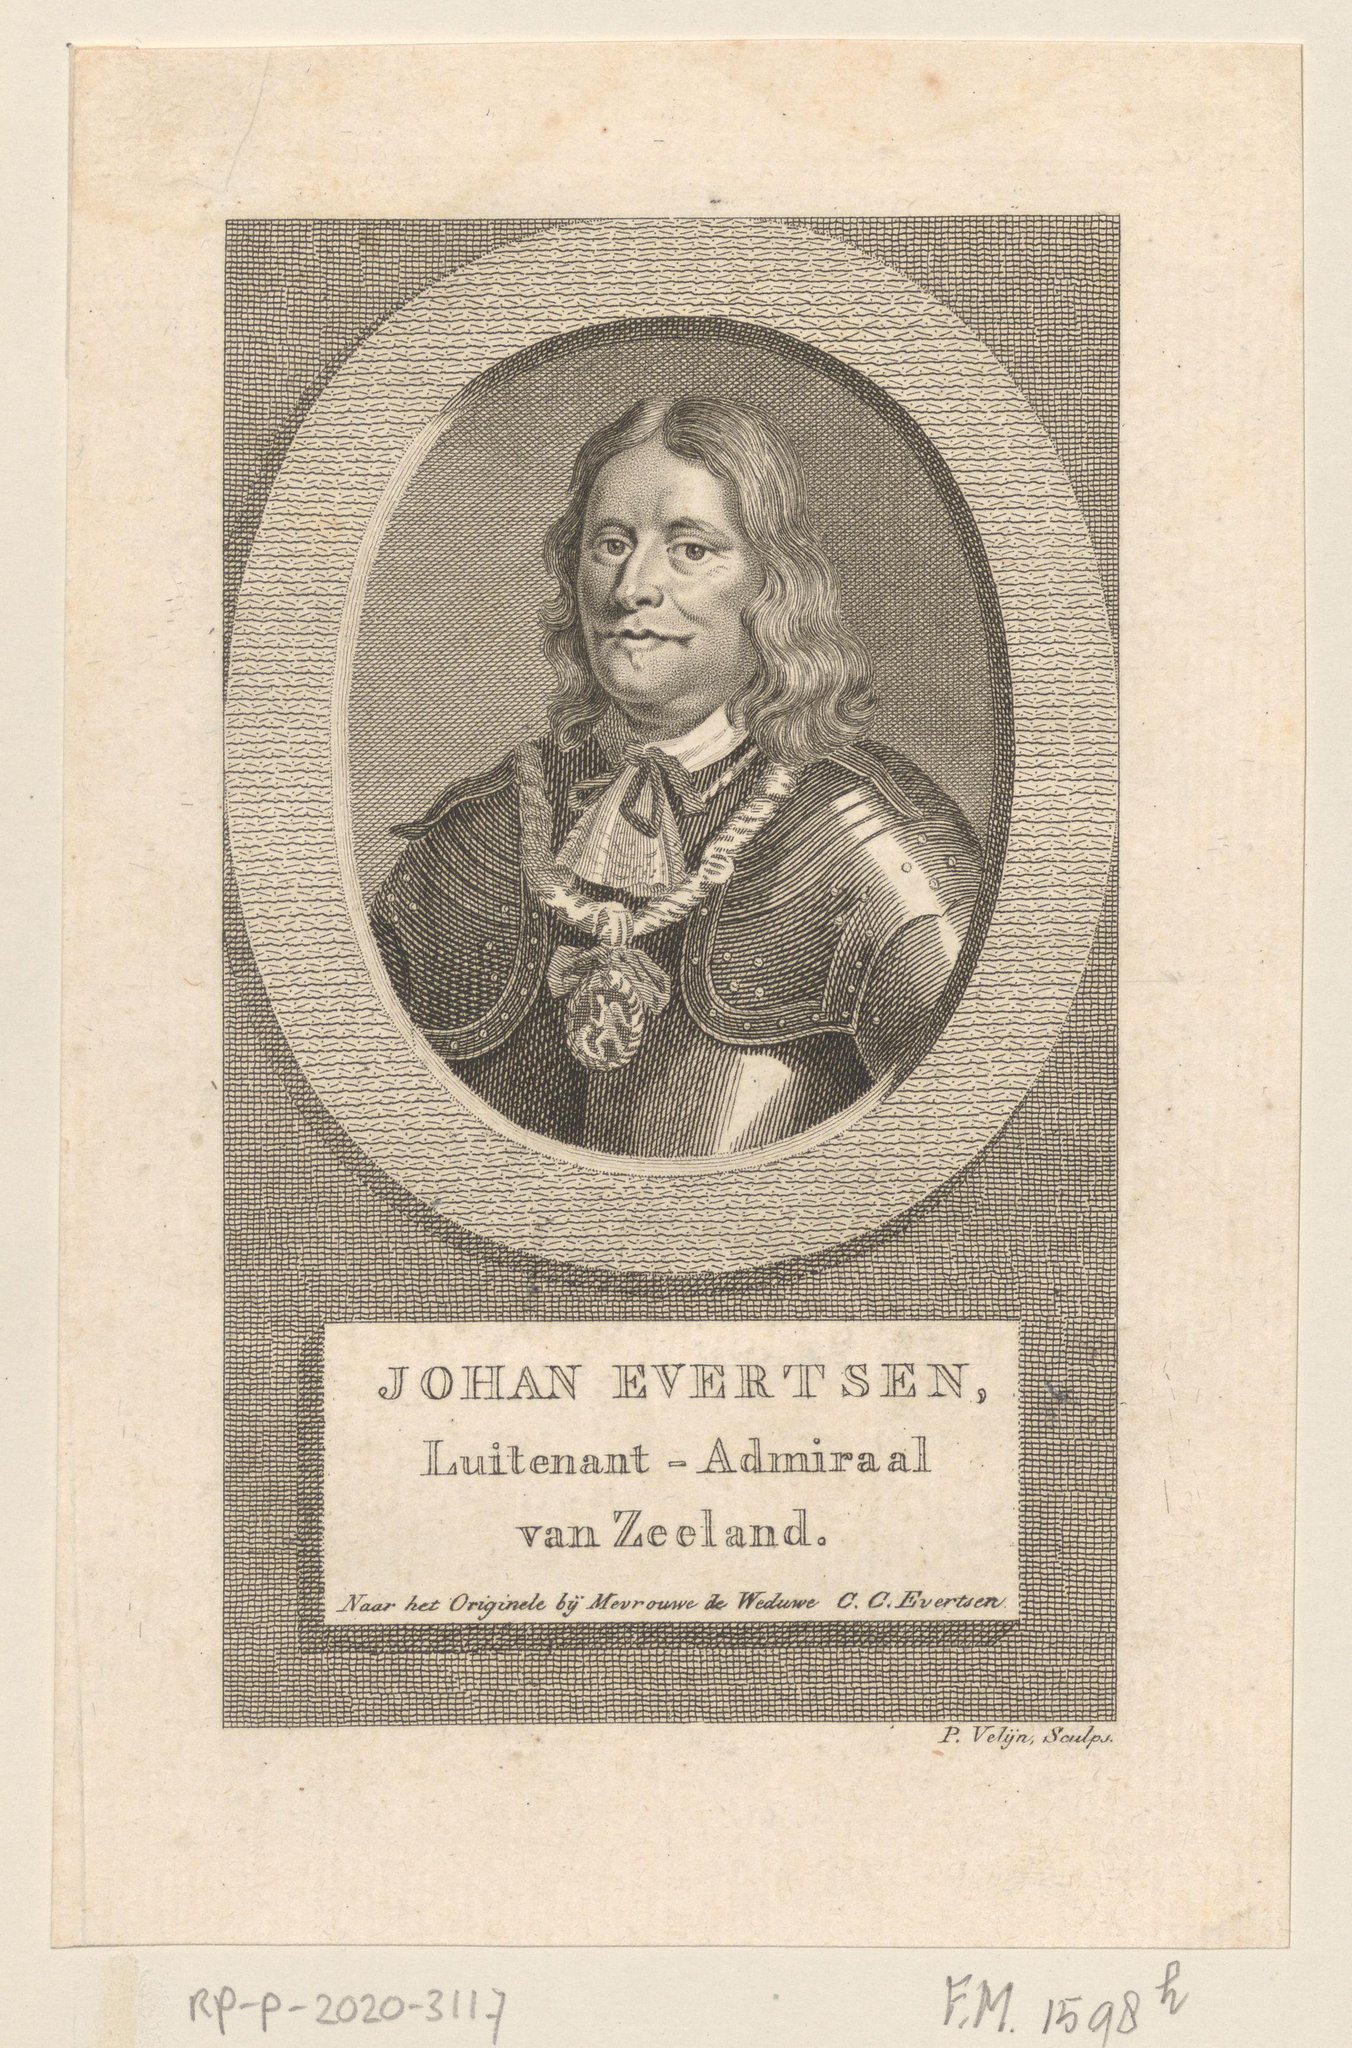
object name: print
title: Portret van Johan Evertsen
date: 1797-1836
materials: paper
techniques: etching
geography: netherlands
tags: flushing, historical persons, commander-in-chief, admiral